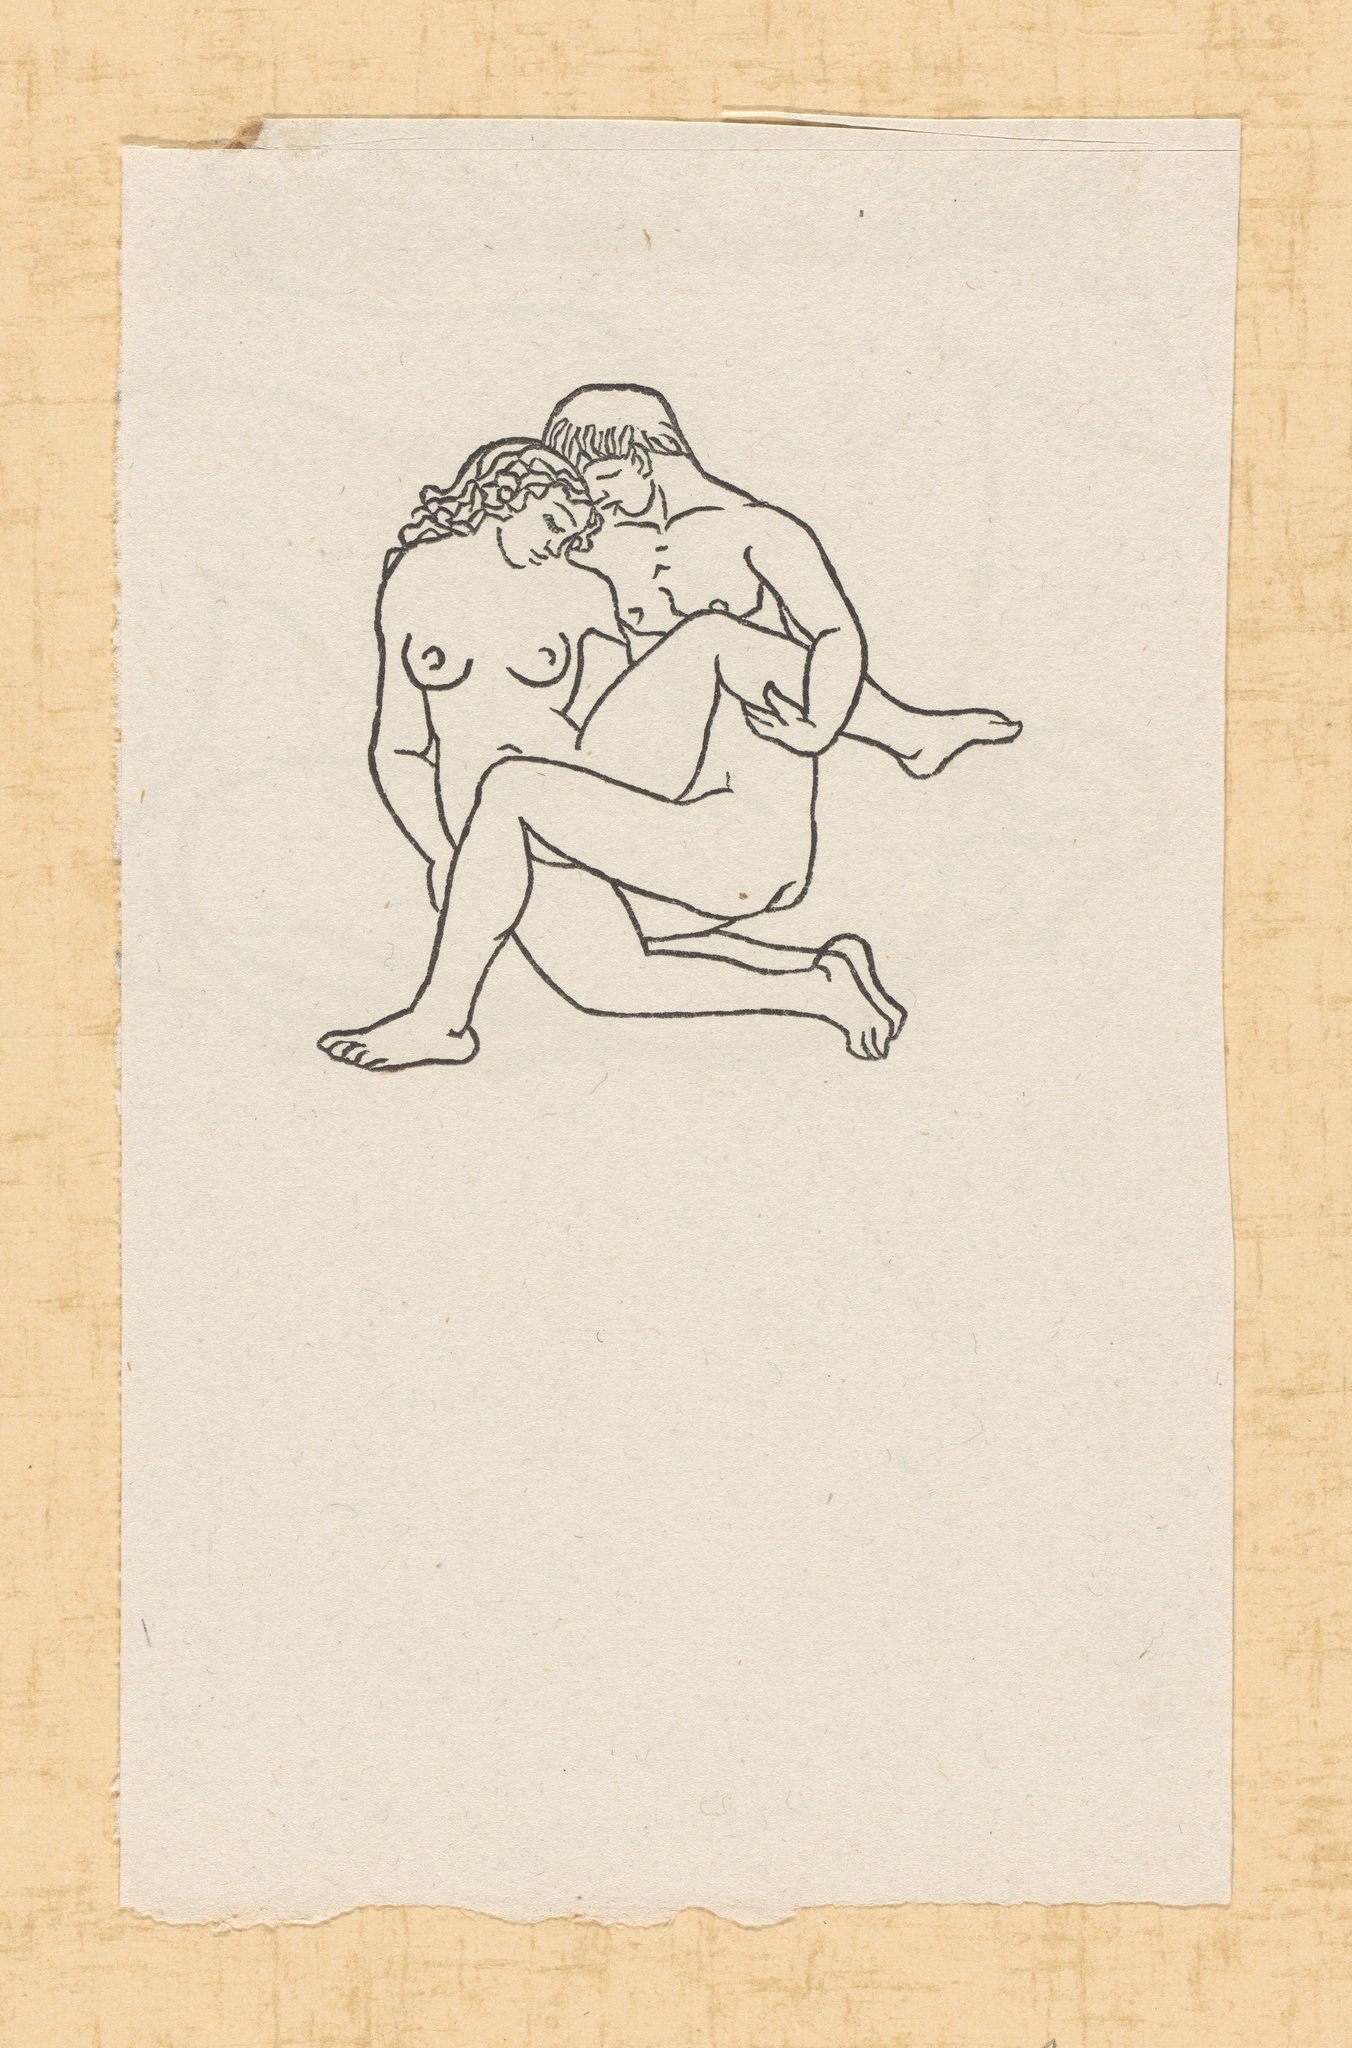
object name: book illustration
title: Vrijend paar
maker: aristide maillol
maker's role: draughtsman, painter, print maker, sculptor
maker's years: 1861-1944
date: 1935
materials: paper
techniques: woodcut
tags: couple of lovers, coitus, cohabiting, sexual intercourse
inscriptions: collector's mark: Lugt 2228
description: Proefdruk van de prent gebruikt in: Ovidius Oublius Naso. L'art d'aimer. Parijs: Émile Charmontin, 1935, p. 122. Op het verso een fragment van een proefdruk van een andere prent voor dezelfde uitgave (Guérin 69).